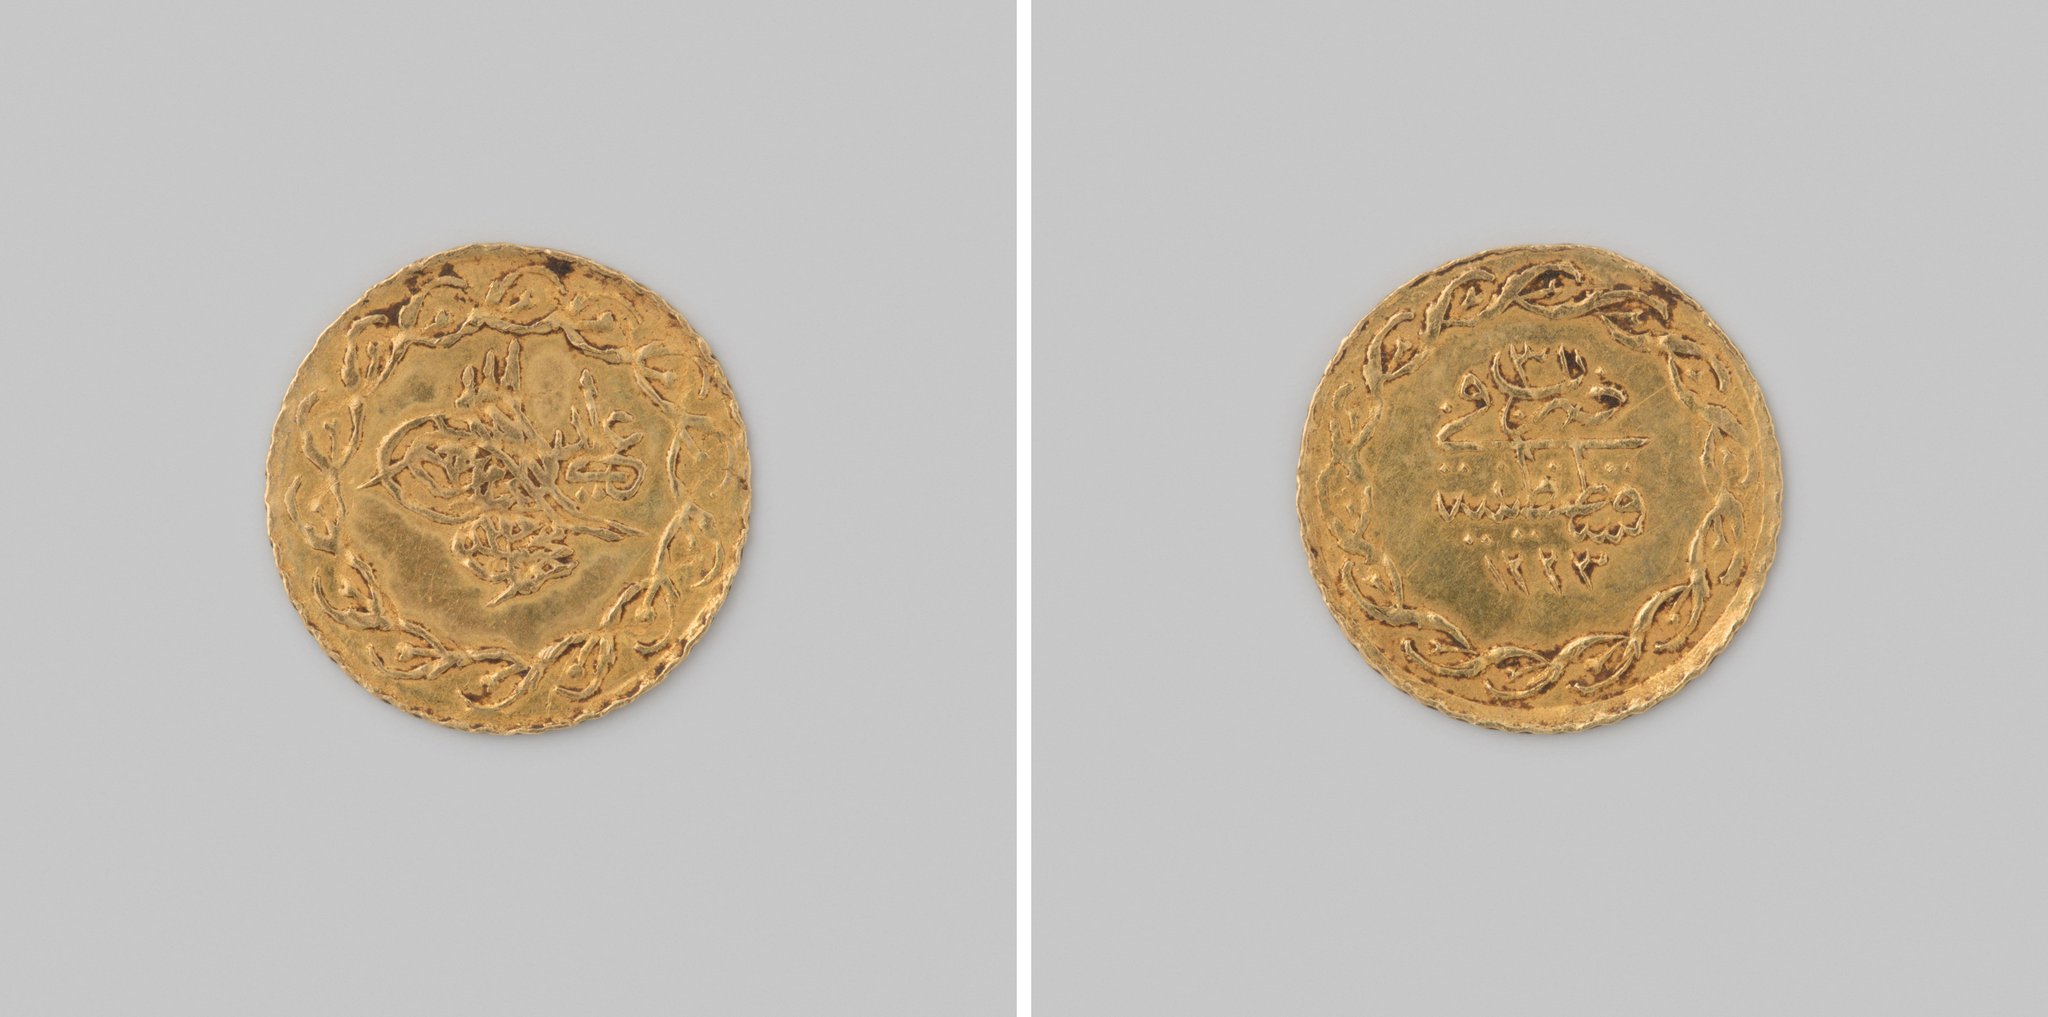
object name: coin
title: 1/4 cedid mahmudiye Turkije van sultan Mahmud II, regeringsjaar 31 [=1838]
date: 1838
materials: gold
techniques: striking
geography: constantinople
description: Gouden munt. Voorzijde: binnen krans van bloemen tughra met rechts daarvan opschrift: adli. Keerzijde: binnen krans van bloemen drieregelig opschrift in Arabische letters met muntplaats-aanduiding: Constantinopel. Boven in opschrift regeringsjaar: 31. Onder muntplaats-aanduiding jaar van aantreden: 1223 [=1808].